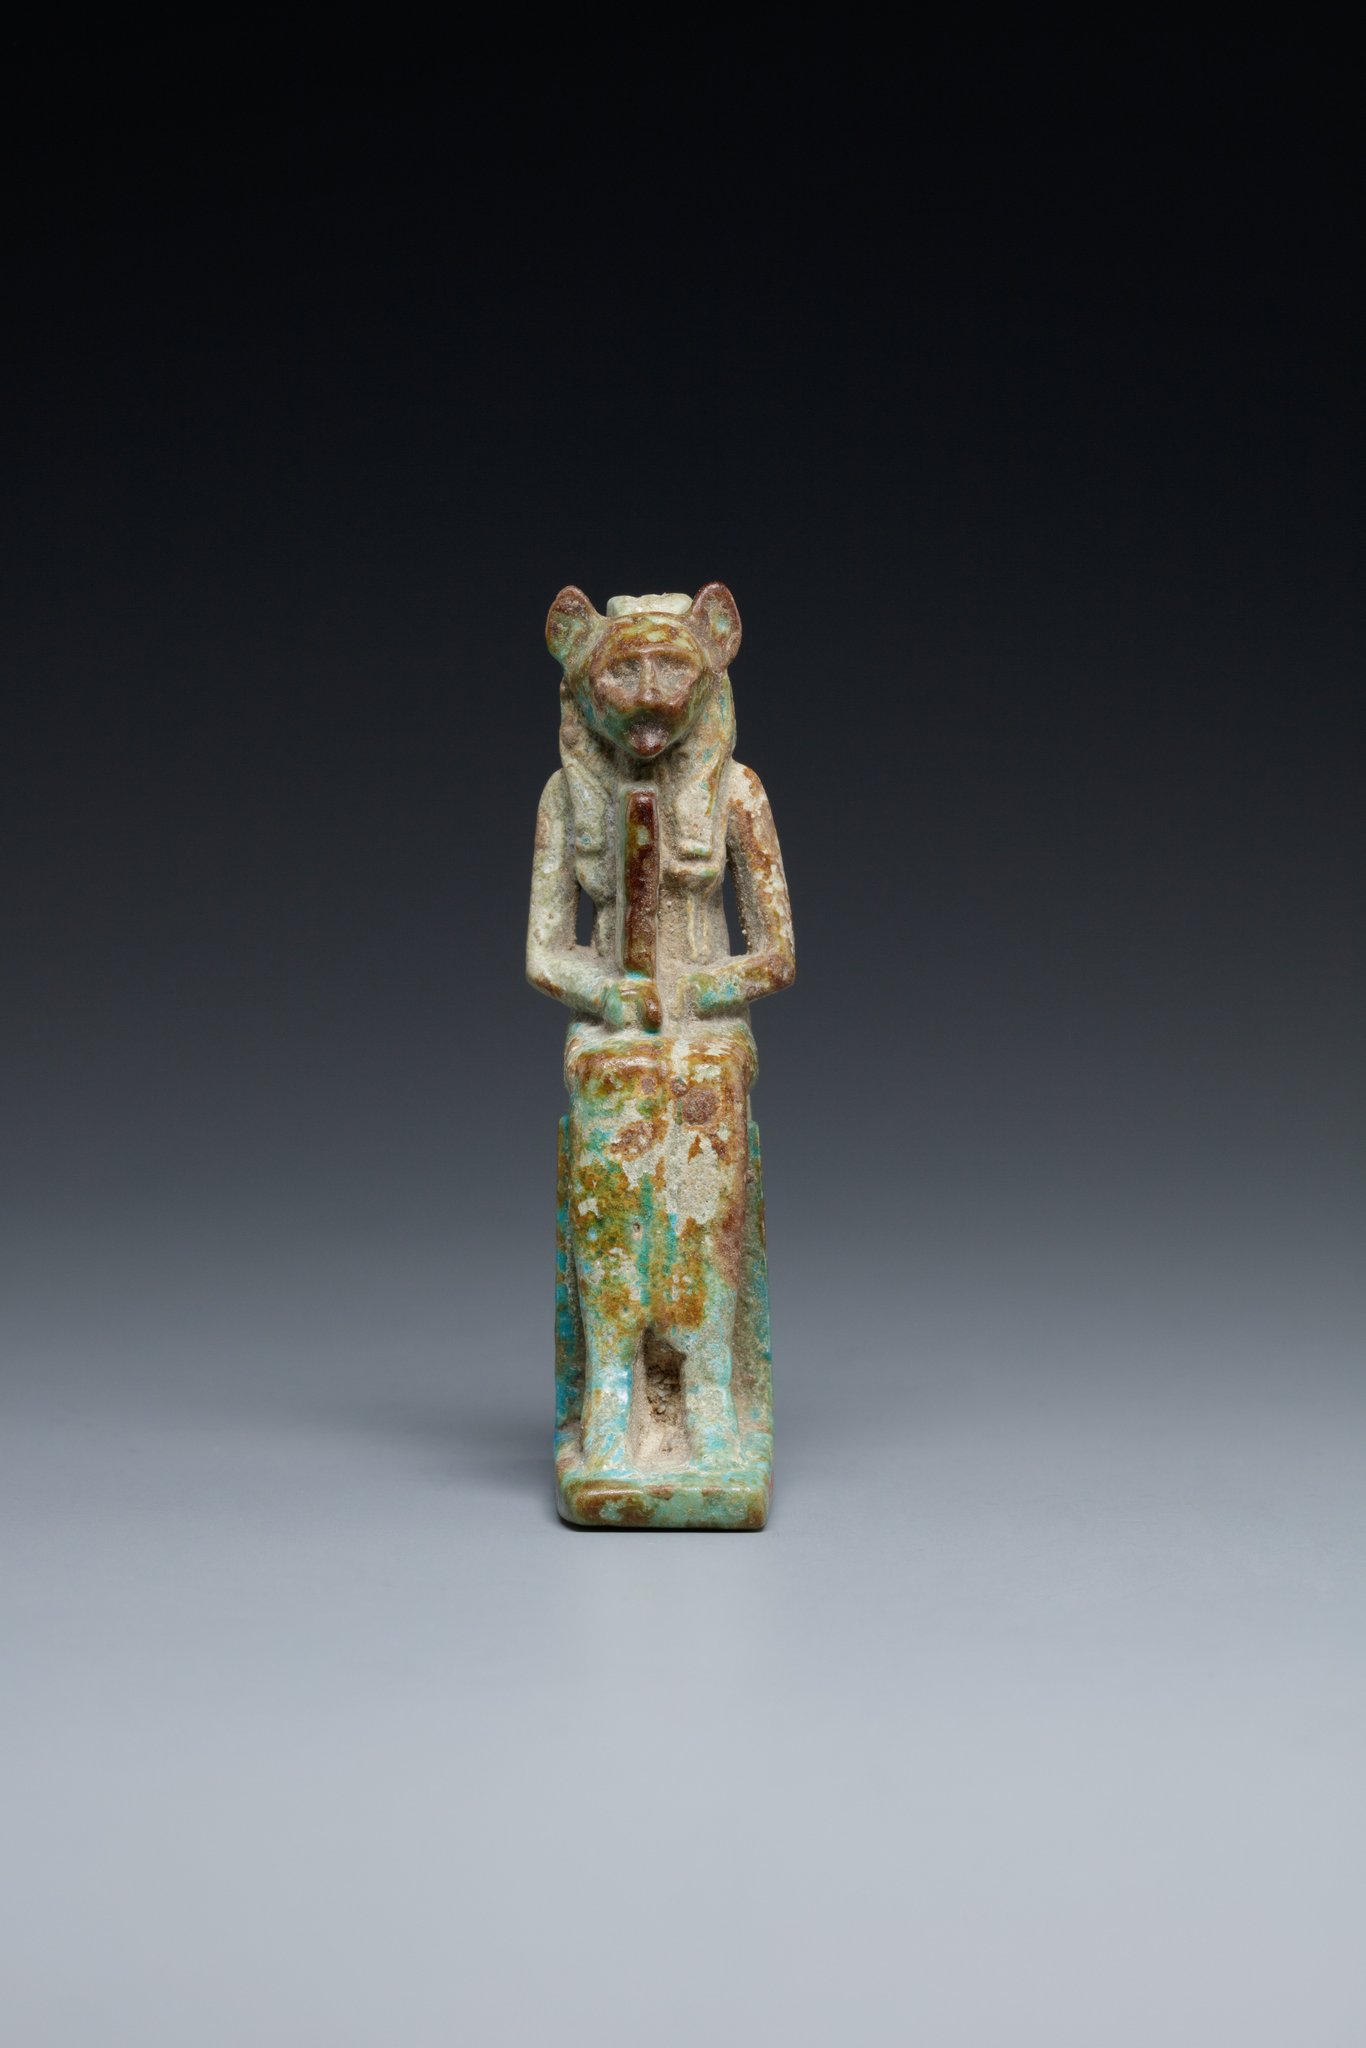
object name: amulet, sakhmet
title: Sakhmet Amulet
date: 664-630 BCE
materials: faience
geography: egypt